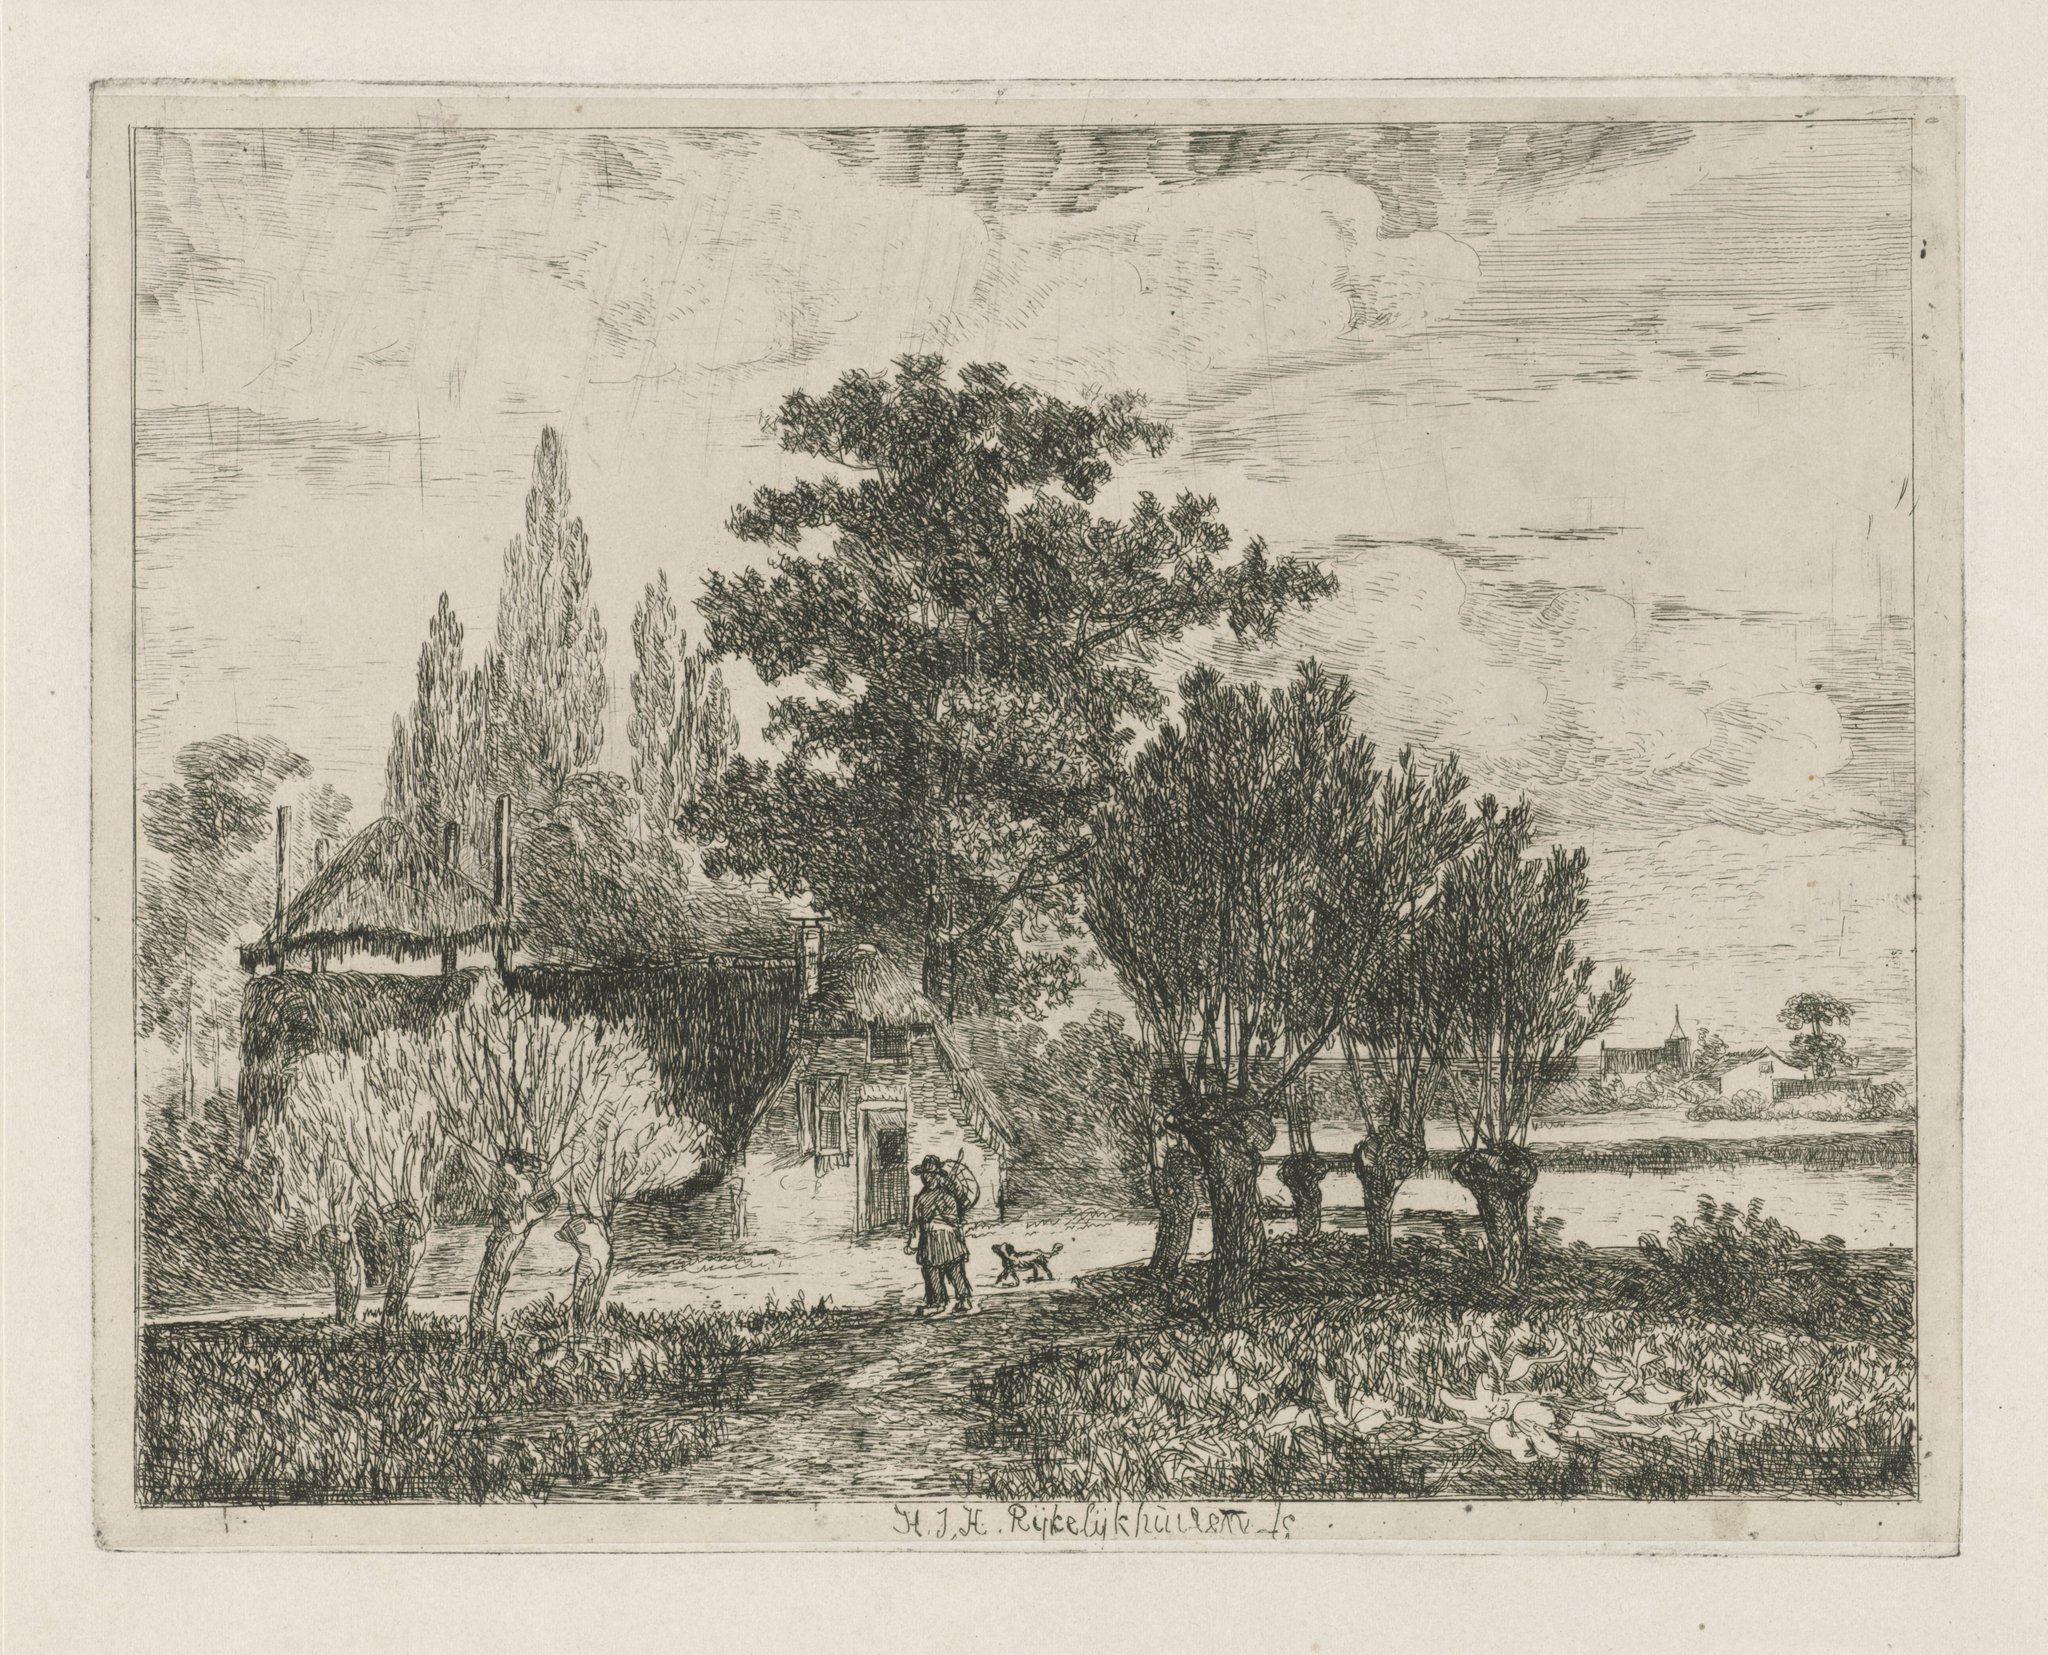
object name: print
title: Marskramer bij een boerenhoeve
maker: hermanus jan hendrik van rijkelijkhuysen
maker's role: painter, print maker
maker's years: 1813-1883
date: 1823-1883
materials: paper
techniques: drypoint, etching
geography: utrecht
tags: church (exterior), farm or solitary house in landscape, dog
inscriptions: collector's mark: Lugt 2228